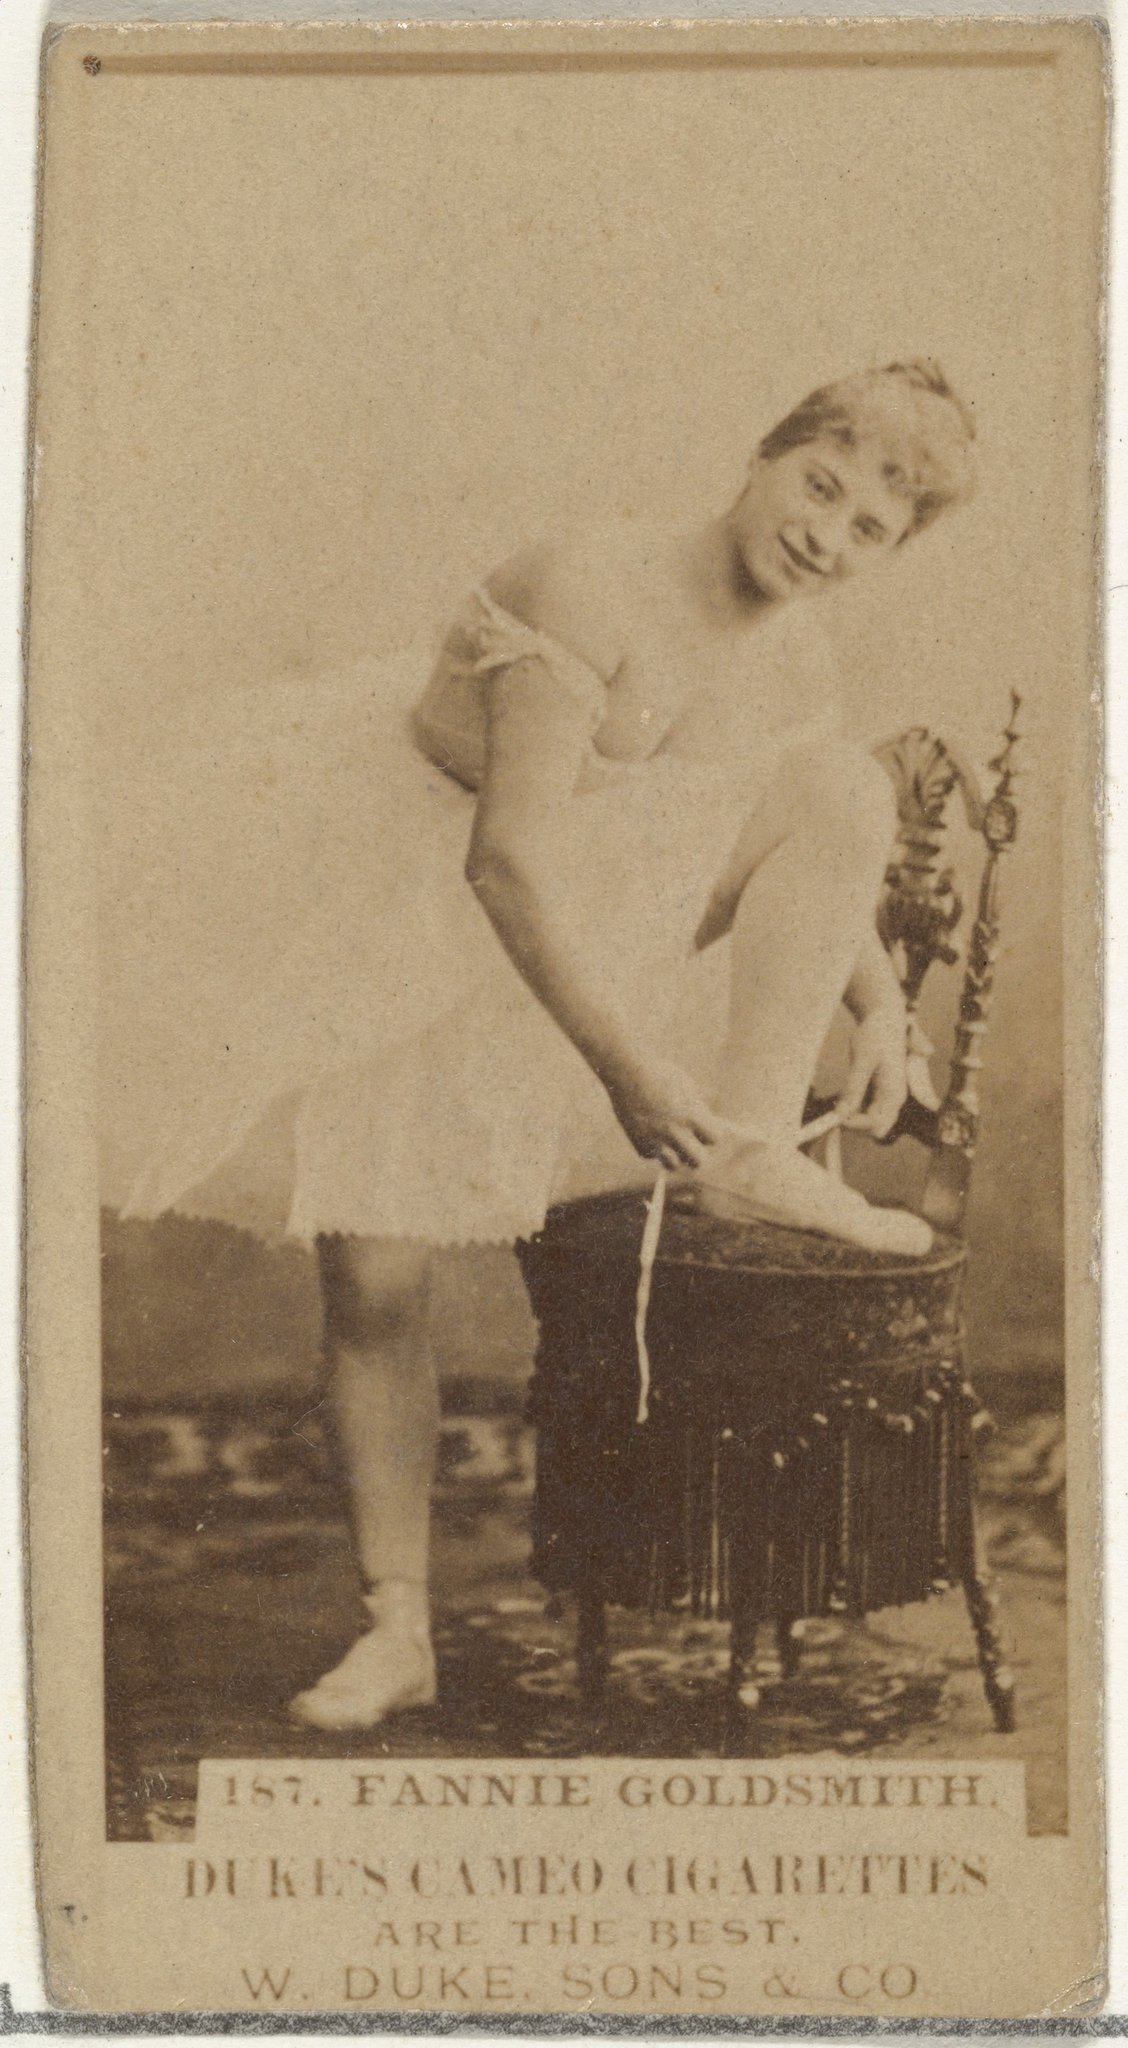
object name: photograph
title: Card Number 187, Fannie Goldsmith, from the Actors and Actresses series (N145-5) issued by Duke Sons & Co. to promote Cameo Cigarettes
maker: w. duke, sons & co.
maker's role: publisher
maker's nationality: american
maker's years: 1870-1920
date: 1880-1889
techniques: albumen silver print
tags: portraits,women,actresses